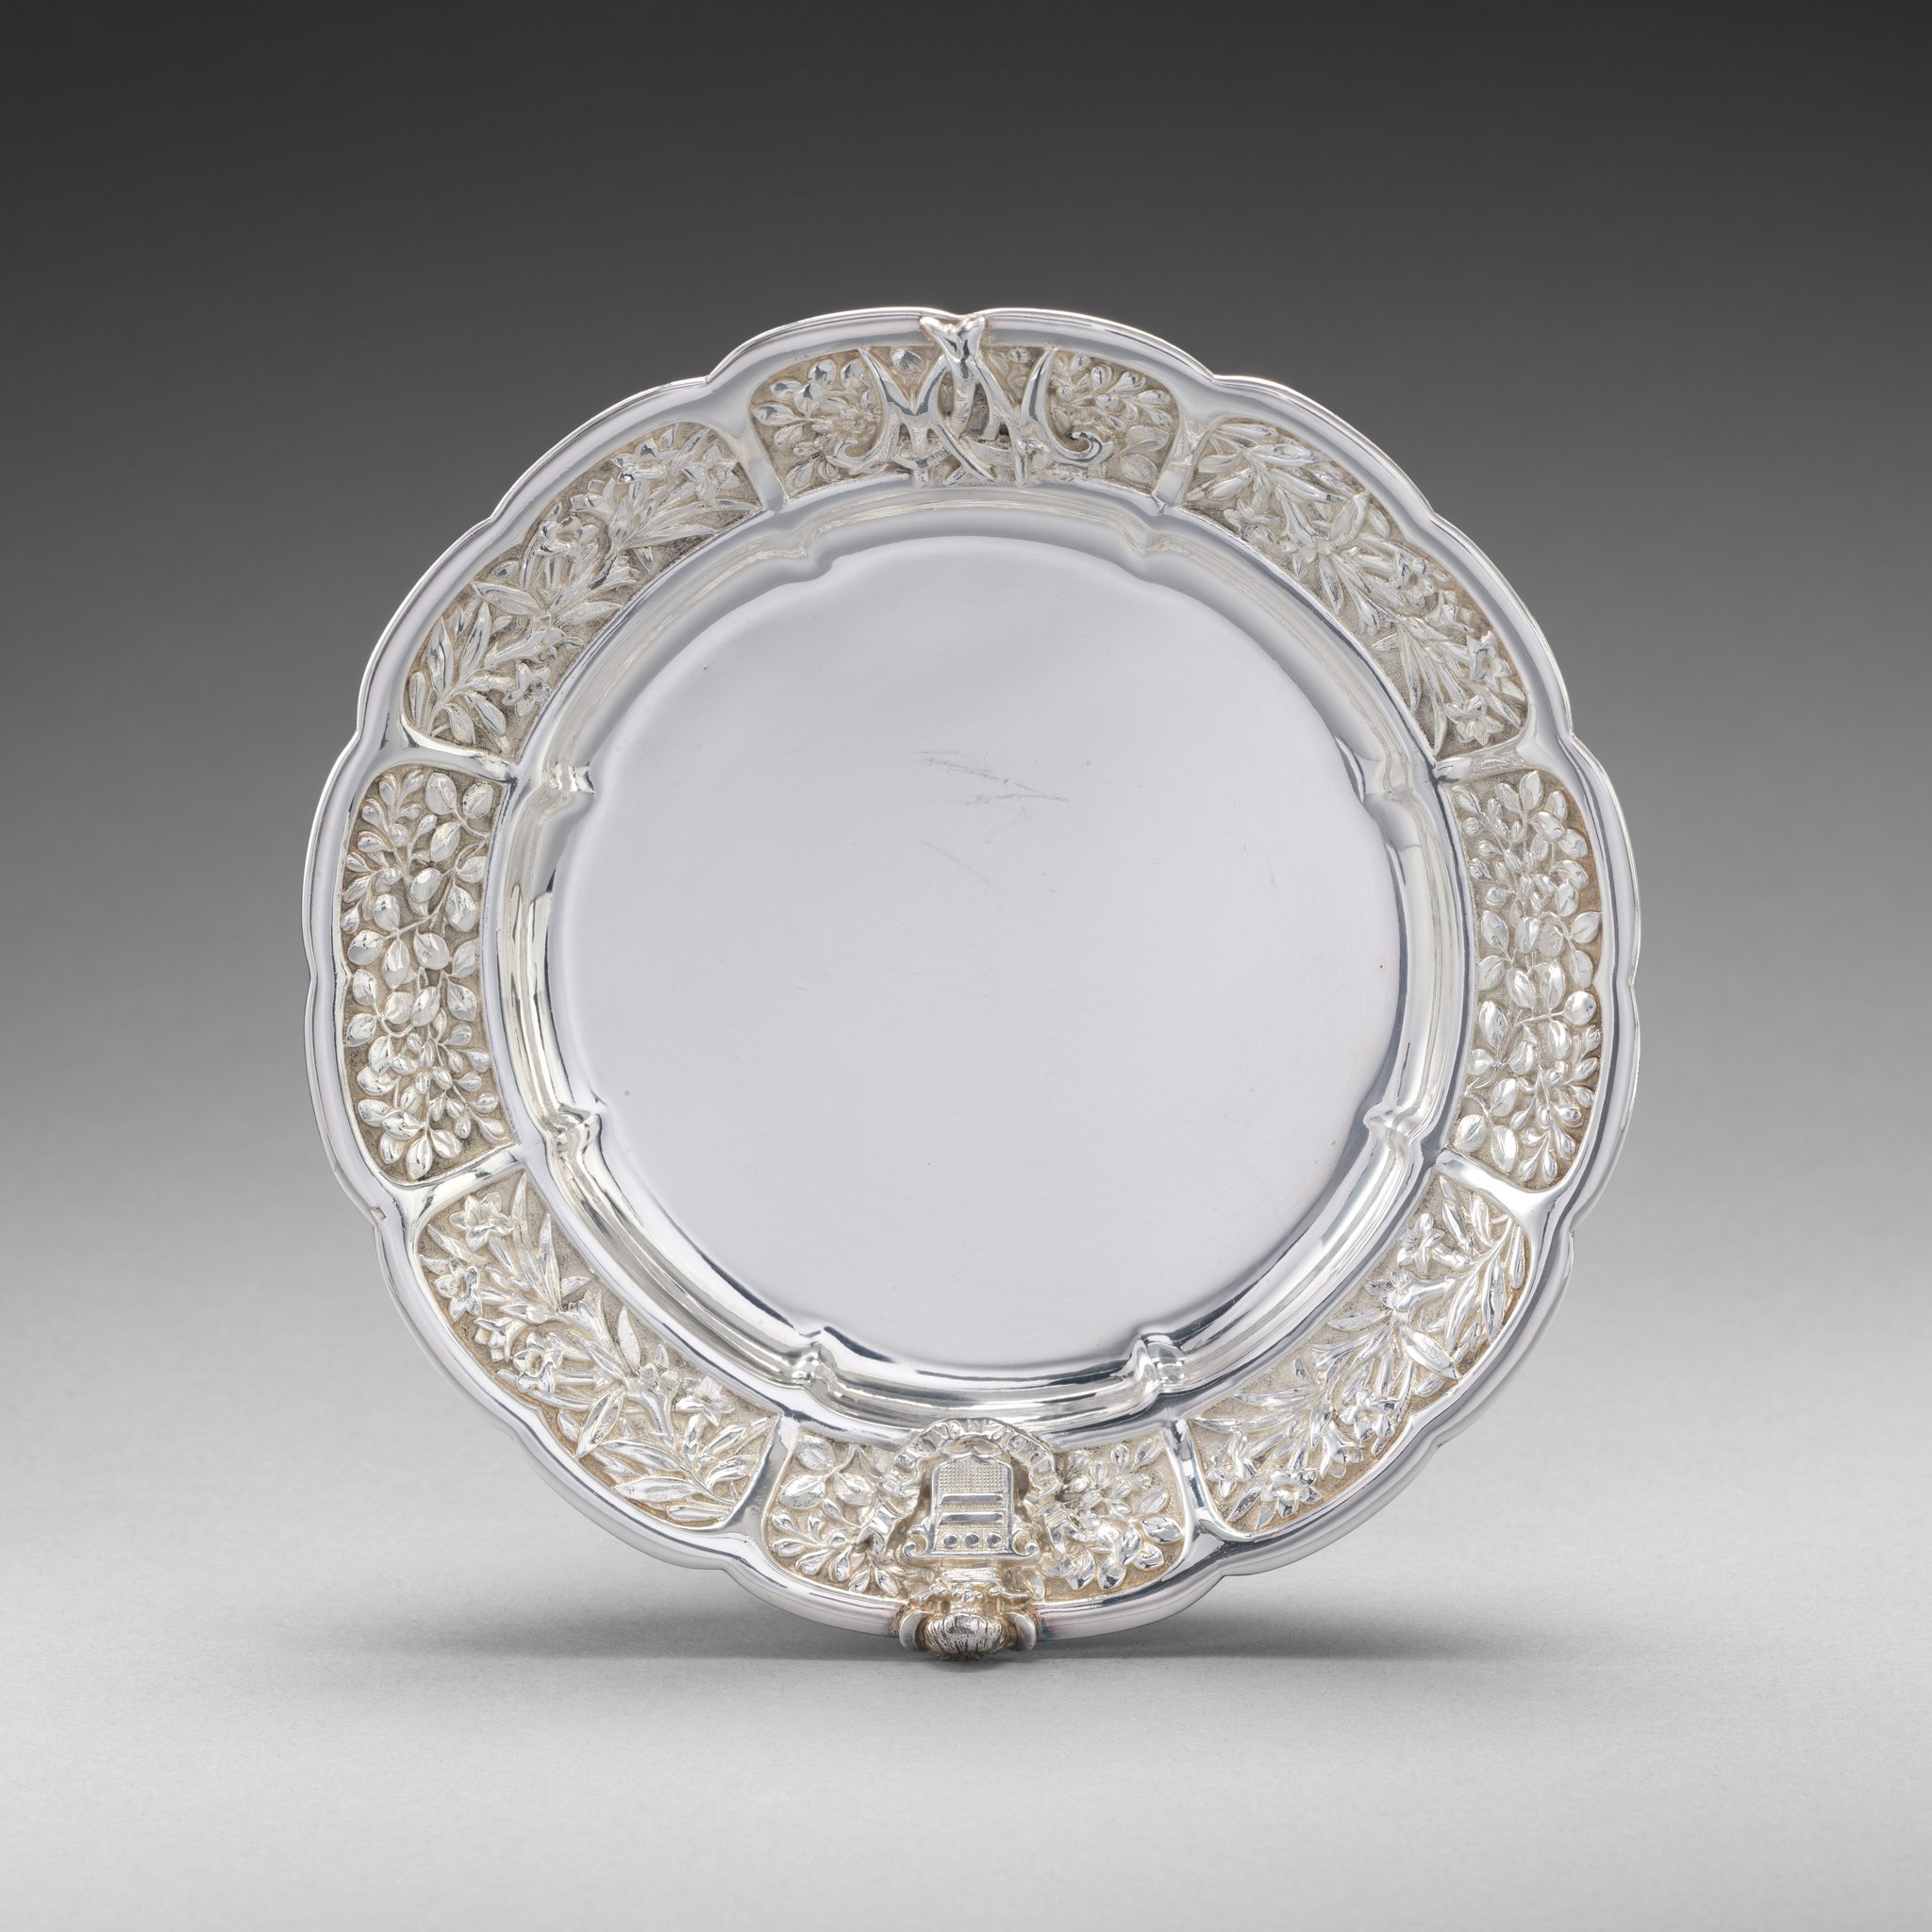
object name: ice cream plate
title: Ice Cream Plate from Mackay Service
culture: american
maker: tiffany & co.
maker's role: maker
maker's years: 1837-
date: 1878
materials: silver